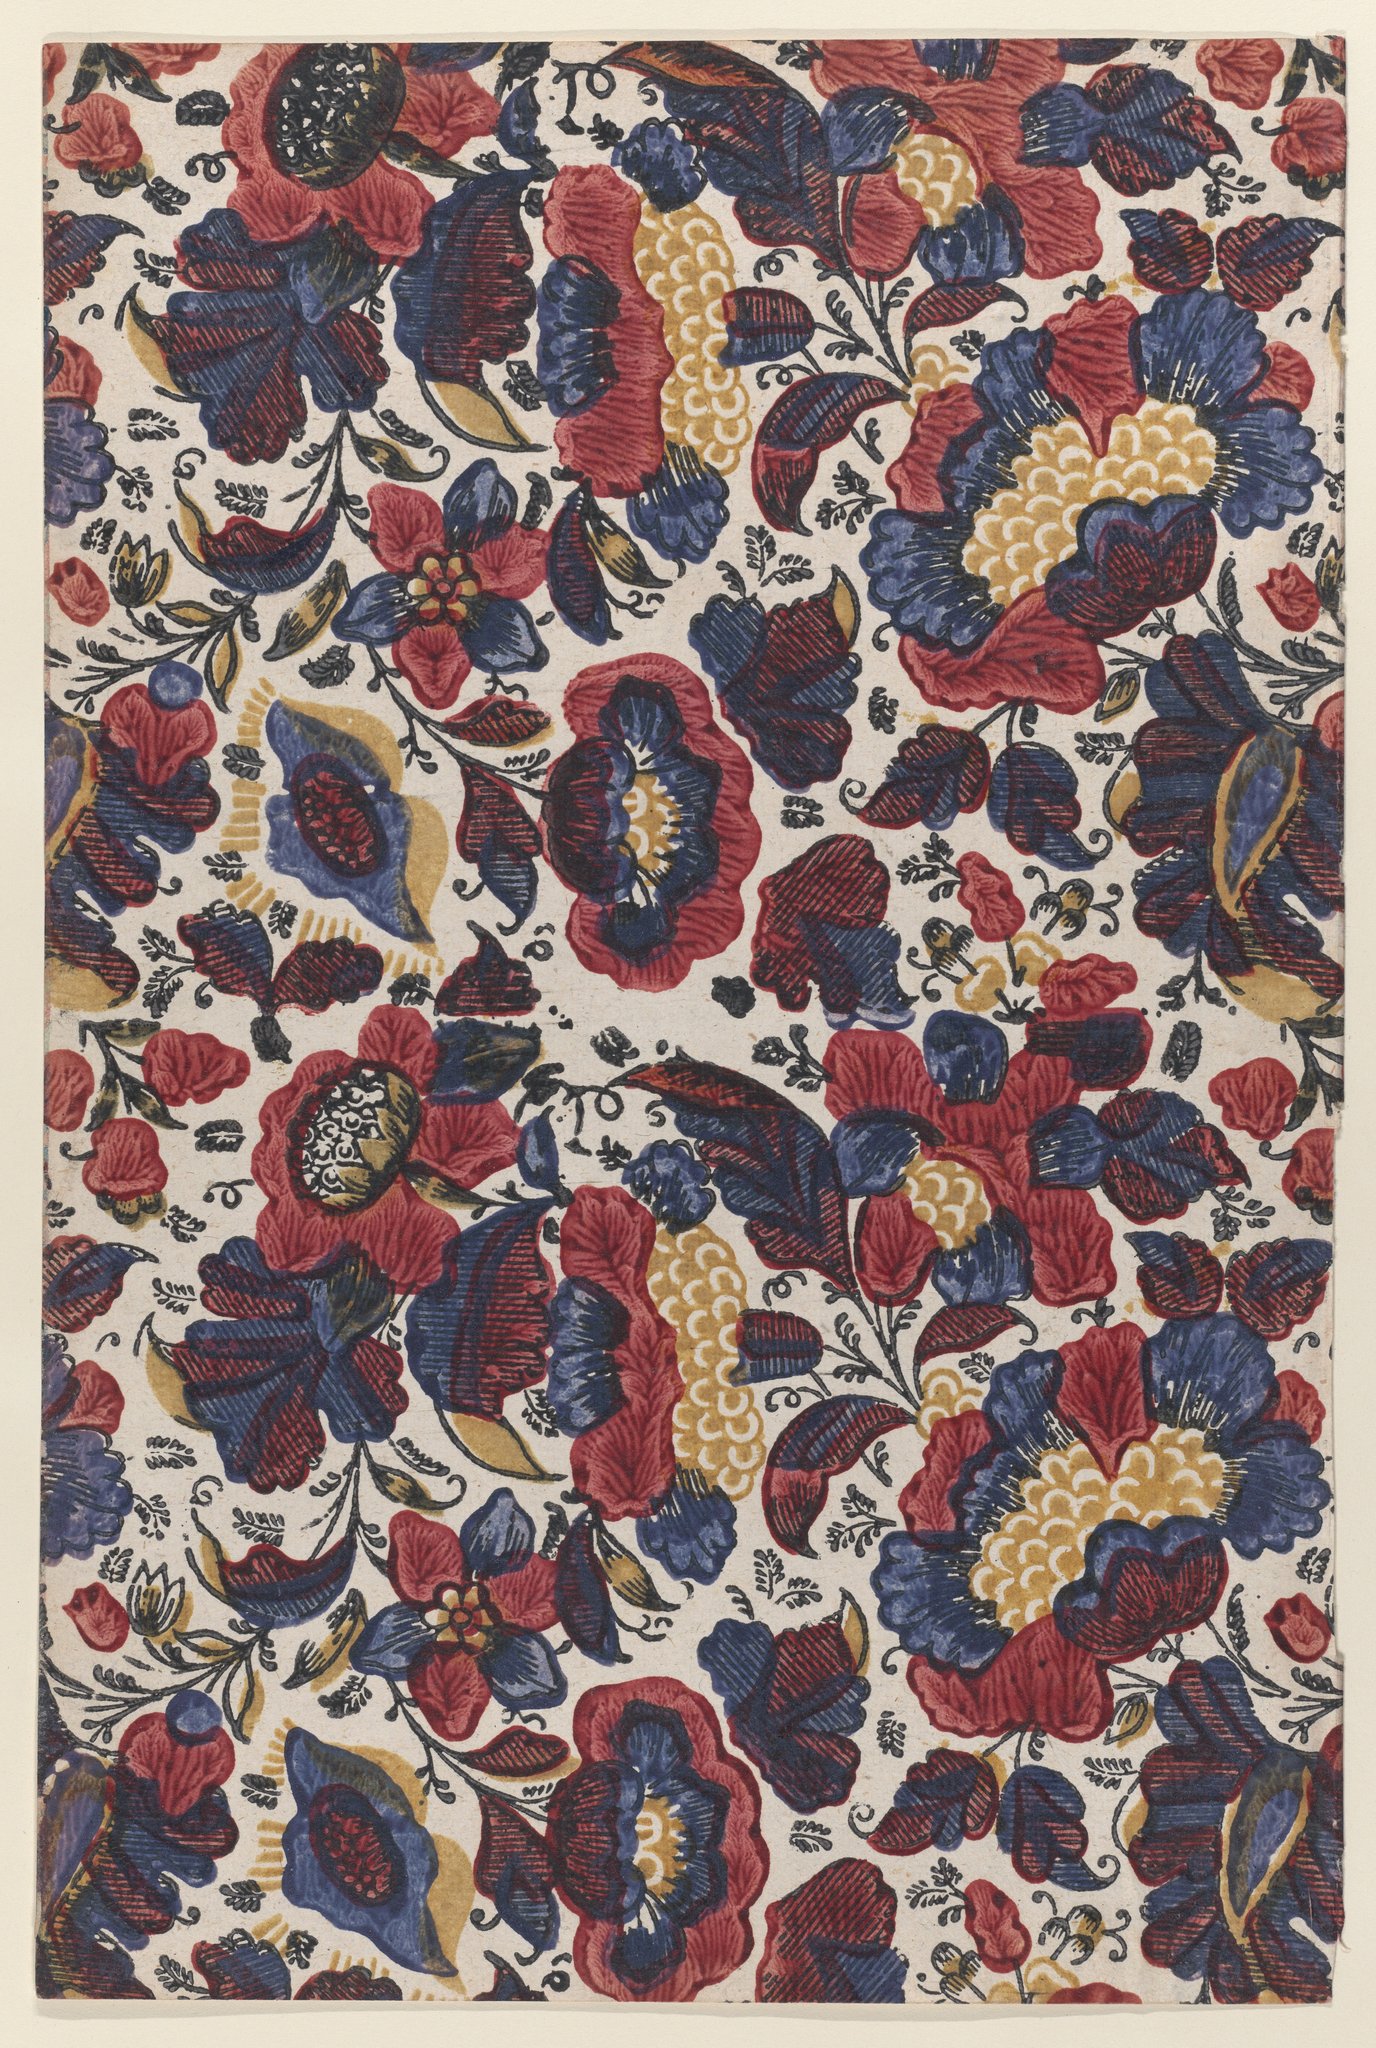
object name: print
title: Paste end paper with overall pattern of red, blue, and yellow flowers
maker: Anonymous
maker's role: artist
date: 1801-1900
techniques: relief print